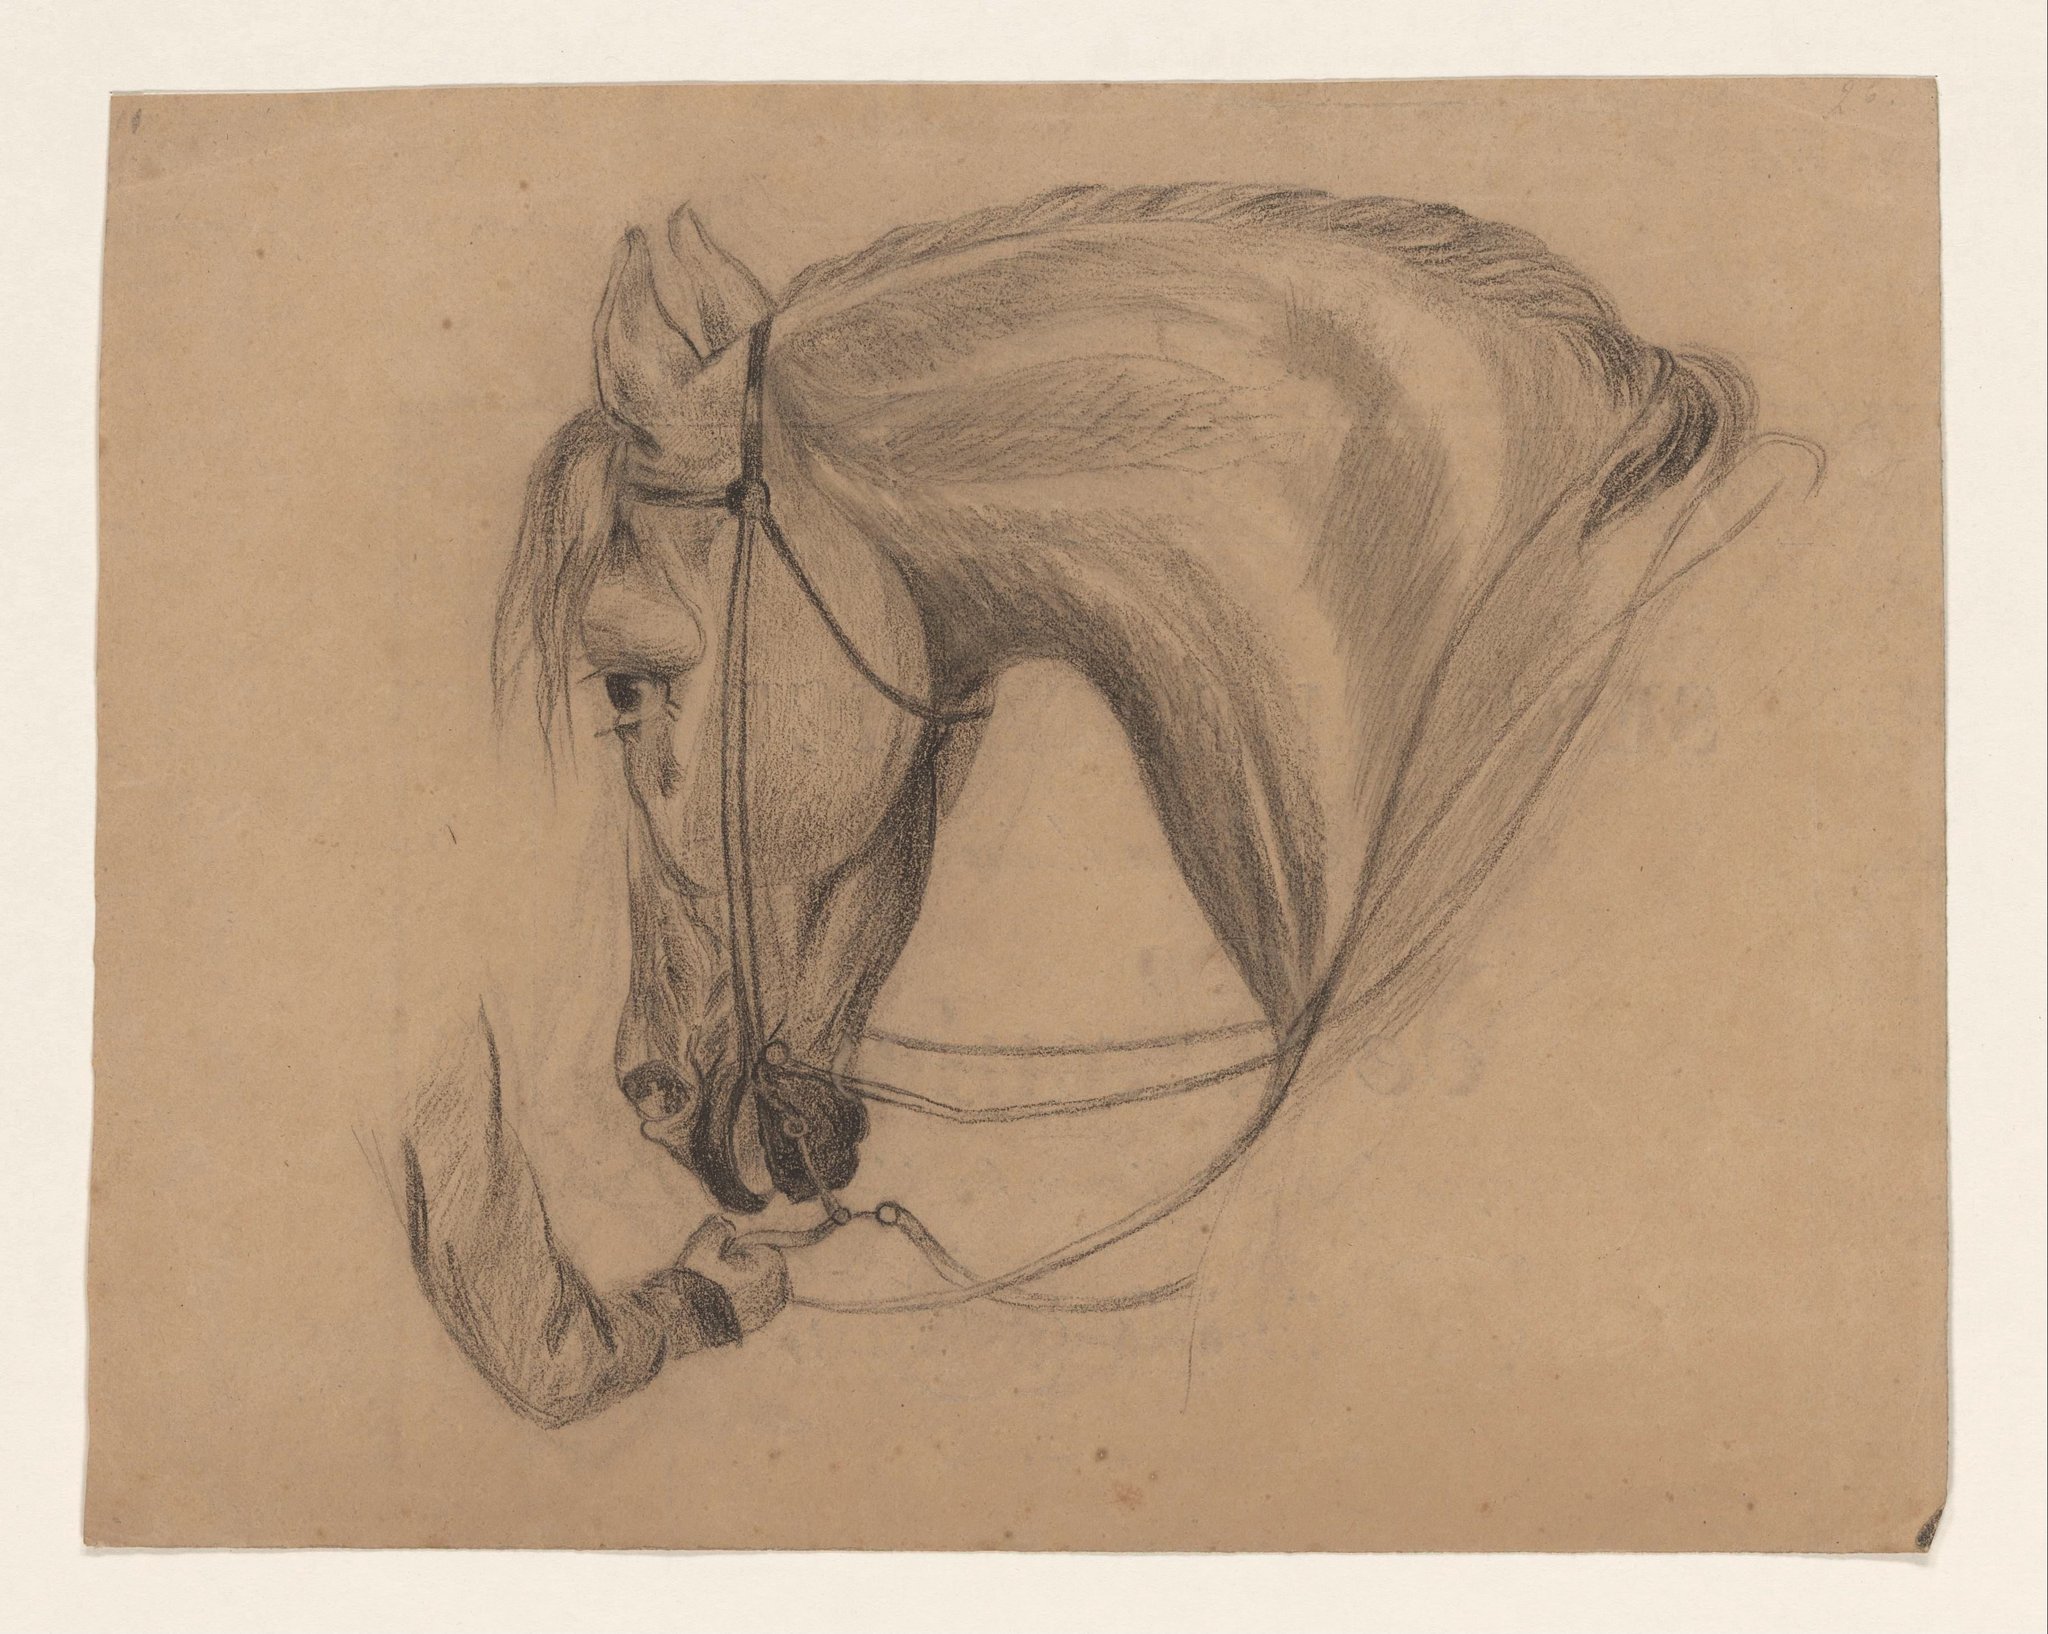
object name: drawing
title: Hoofd van een paard, naar links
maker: johannes tavenraat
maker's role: draughtsman, painter, print maker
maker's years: 1809-1881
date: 1819-1881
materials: chalk, paper, pencil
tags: horse